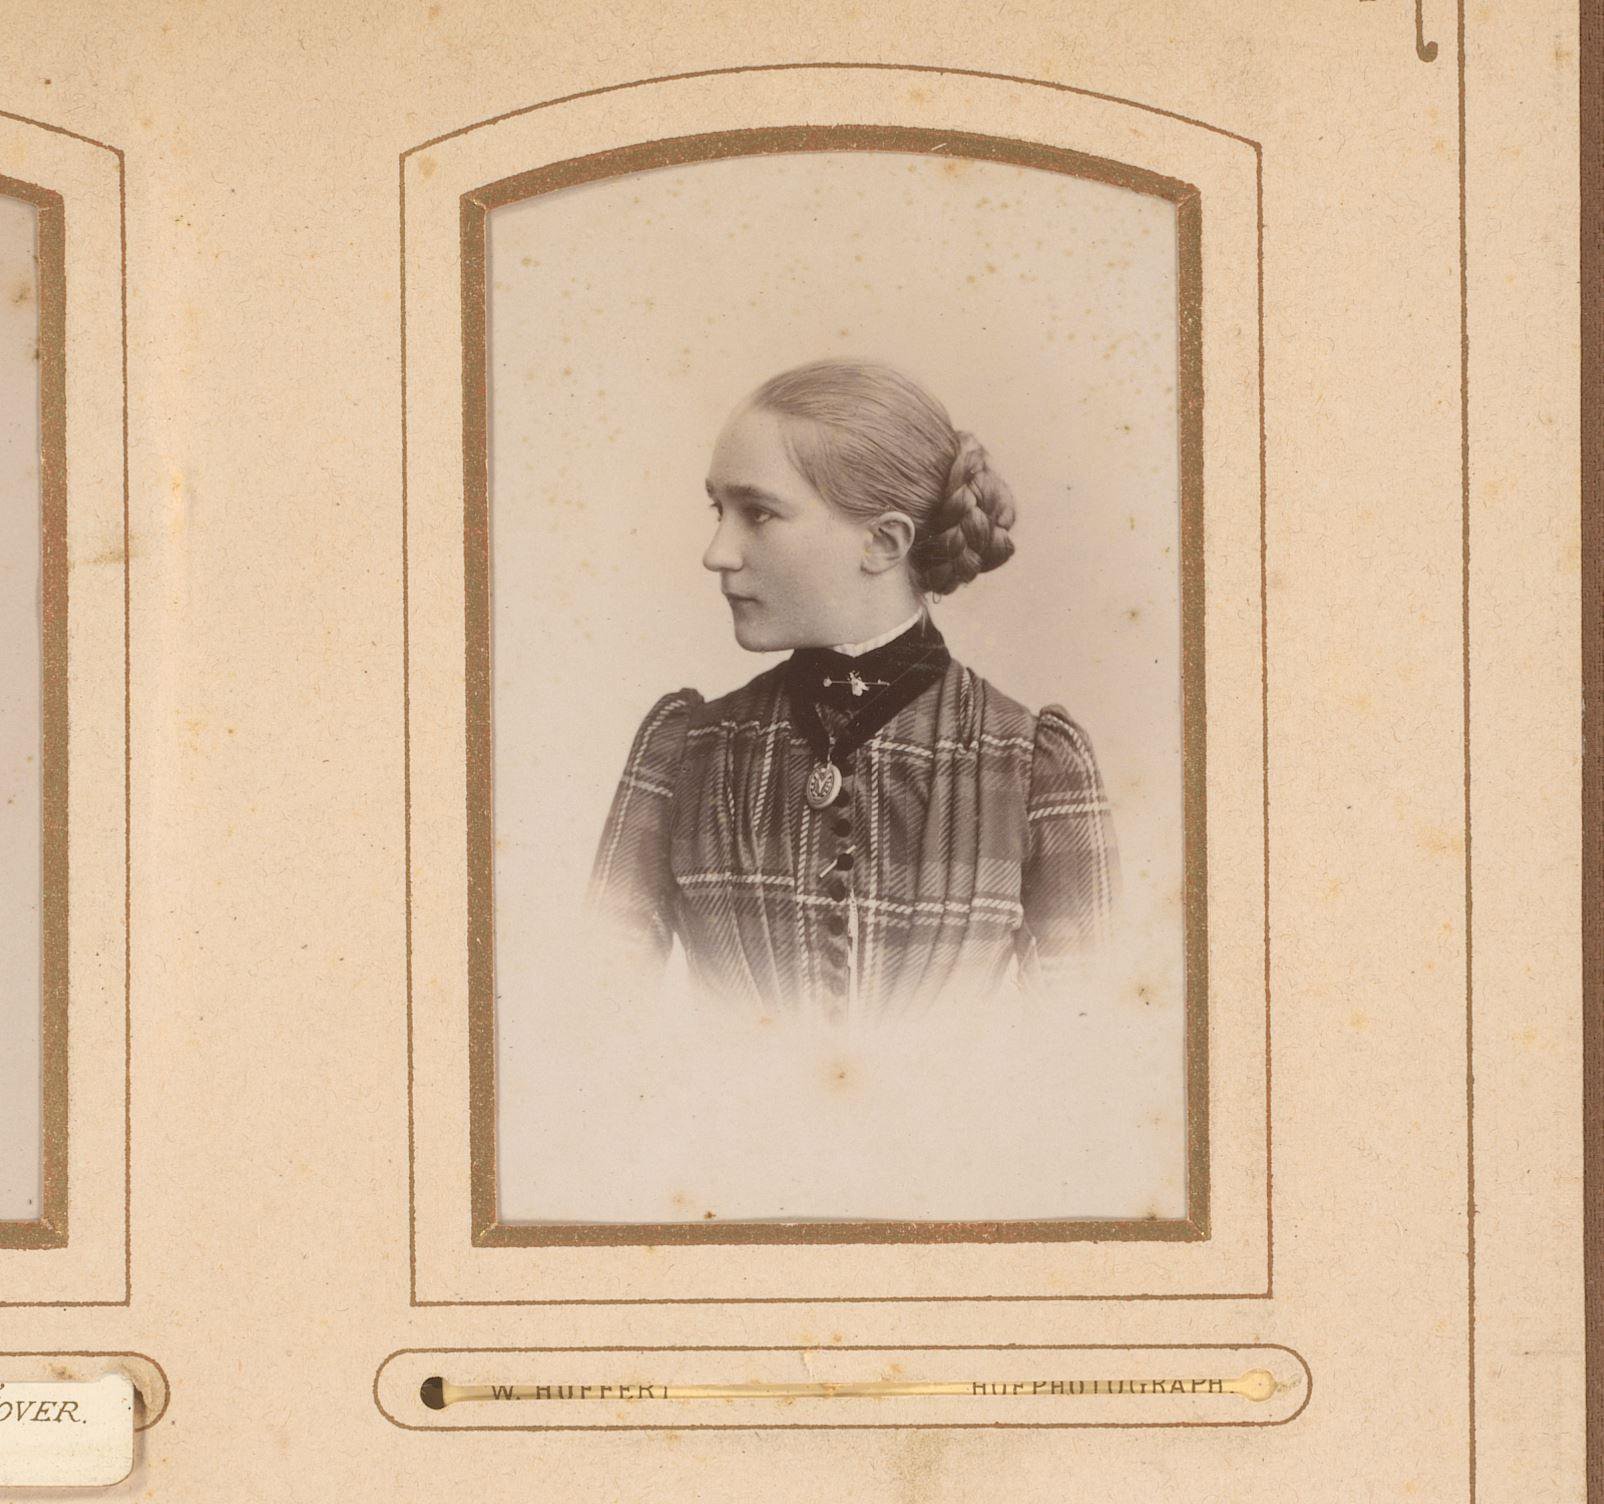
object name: carte de visite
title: Portret van een meisje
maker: wilhelm höffert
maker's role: fotograaf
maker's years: 1832-1901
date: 1874-1900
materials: cardboard, photographic support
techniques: albumen print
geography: germany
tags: girl (child between toddler and youth)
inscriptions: inscription: ‘W. Hoffert/ Hofphotograph’